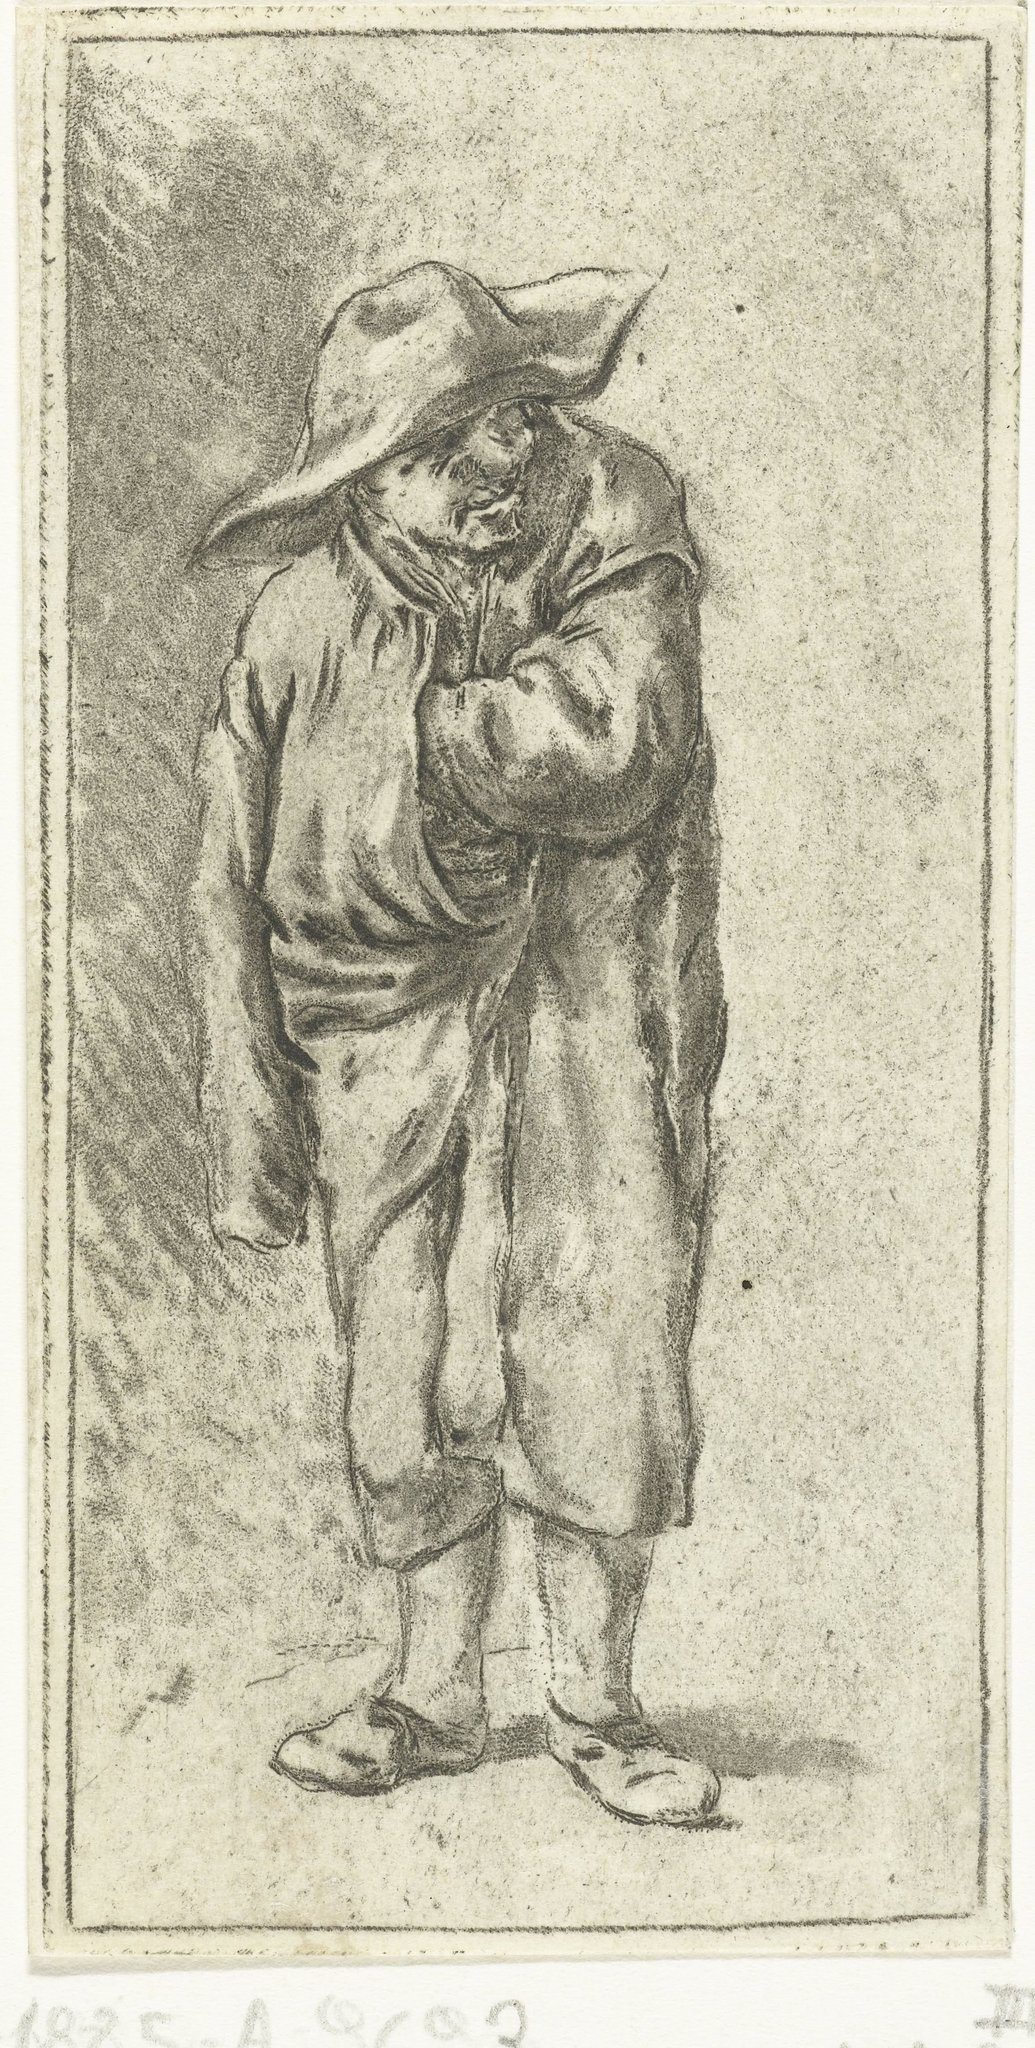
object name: print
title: Staande boer met hand en arm in zijn mantel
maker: jurriaan cootwijck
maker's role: print maker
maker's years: 1714-1798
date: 1724-1798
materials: paper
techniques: print drawing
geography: haarlem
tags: farmers, beggar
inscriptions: collector's mark: Lugt 2228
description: Een man met een grote hoed, staande naar rechts. Zijn hand en arm in zijn mantel.